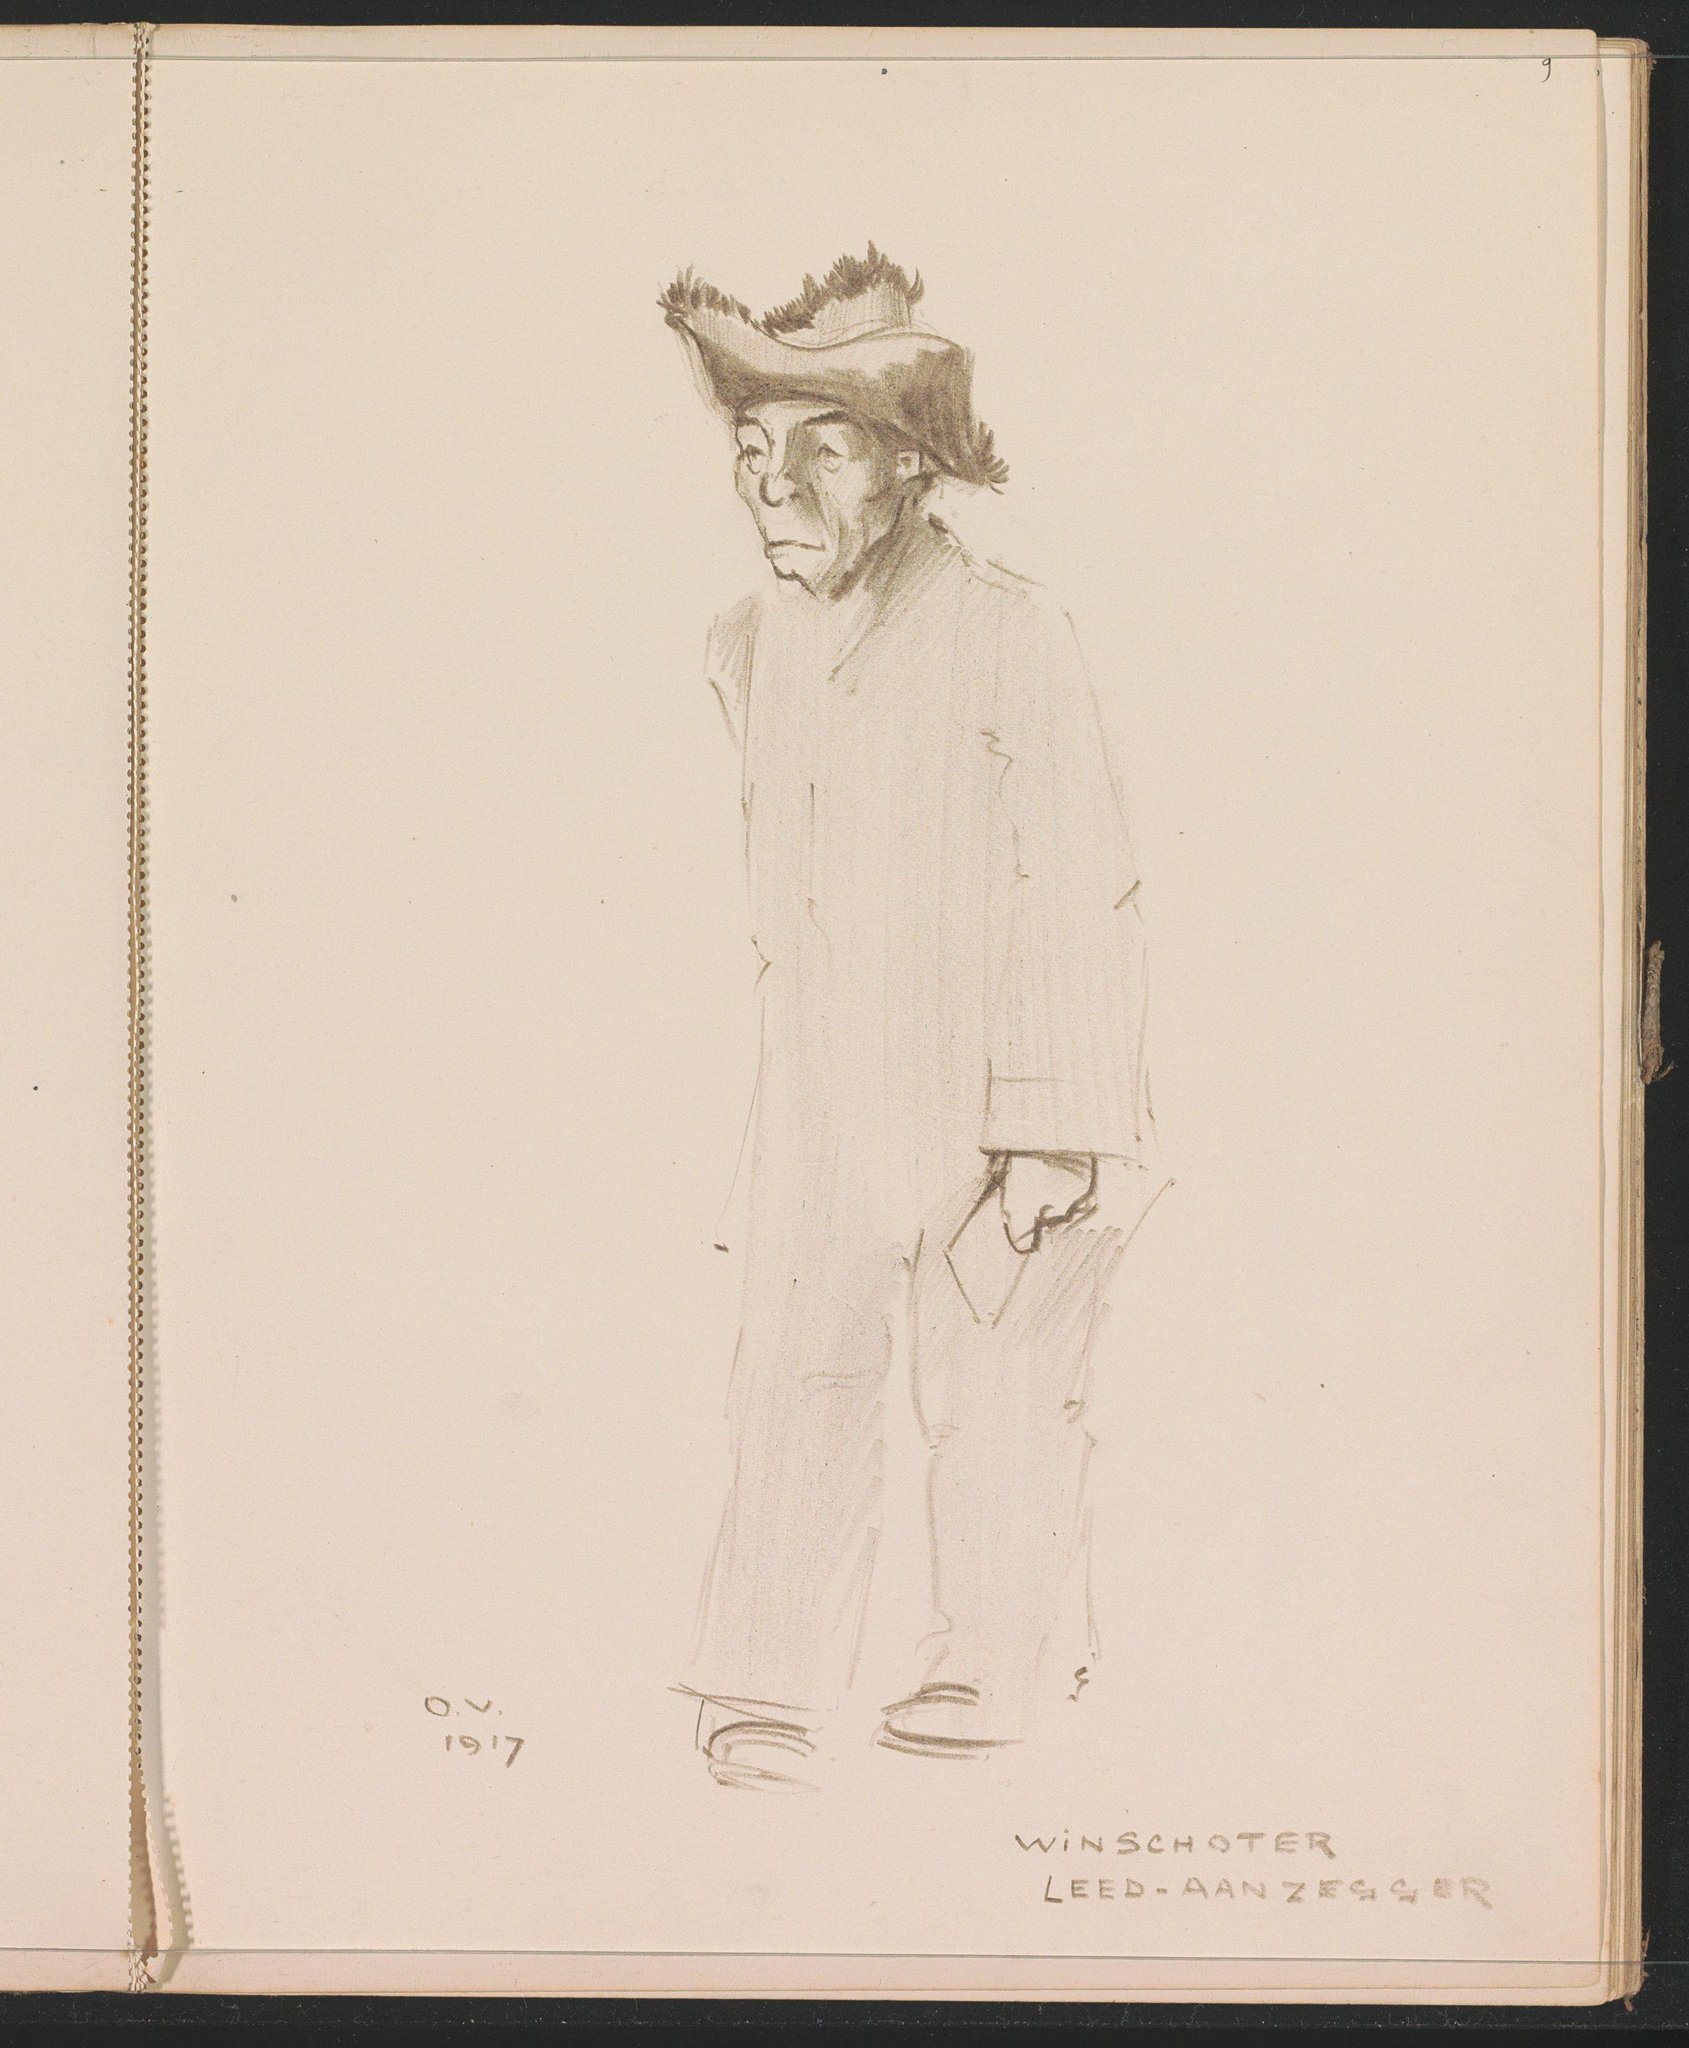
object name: sketchbook leaf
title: Winschoter leedaanzegger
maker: otto verhagen (i)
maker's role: draughtsman, print maker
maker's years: 1885-1951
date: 1917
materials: chalk, paper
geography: winschoten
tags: messenger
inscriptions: date and inscription: ‘o.v./ 1917/ WINSCHOTER/ LEED-AANZEGGER’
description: De oudere man draagt een eenvoudig pak en gerafelde hoed en heeft een vel papier in de hand. Pagina 9 uit een schetsboek met 28 bladen.